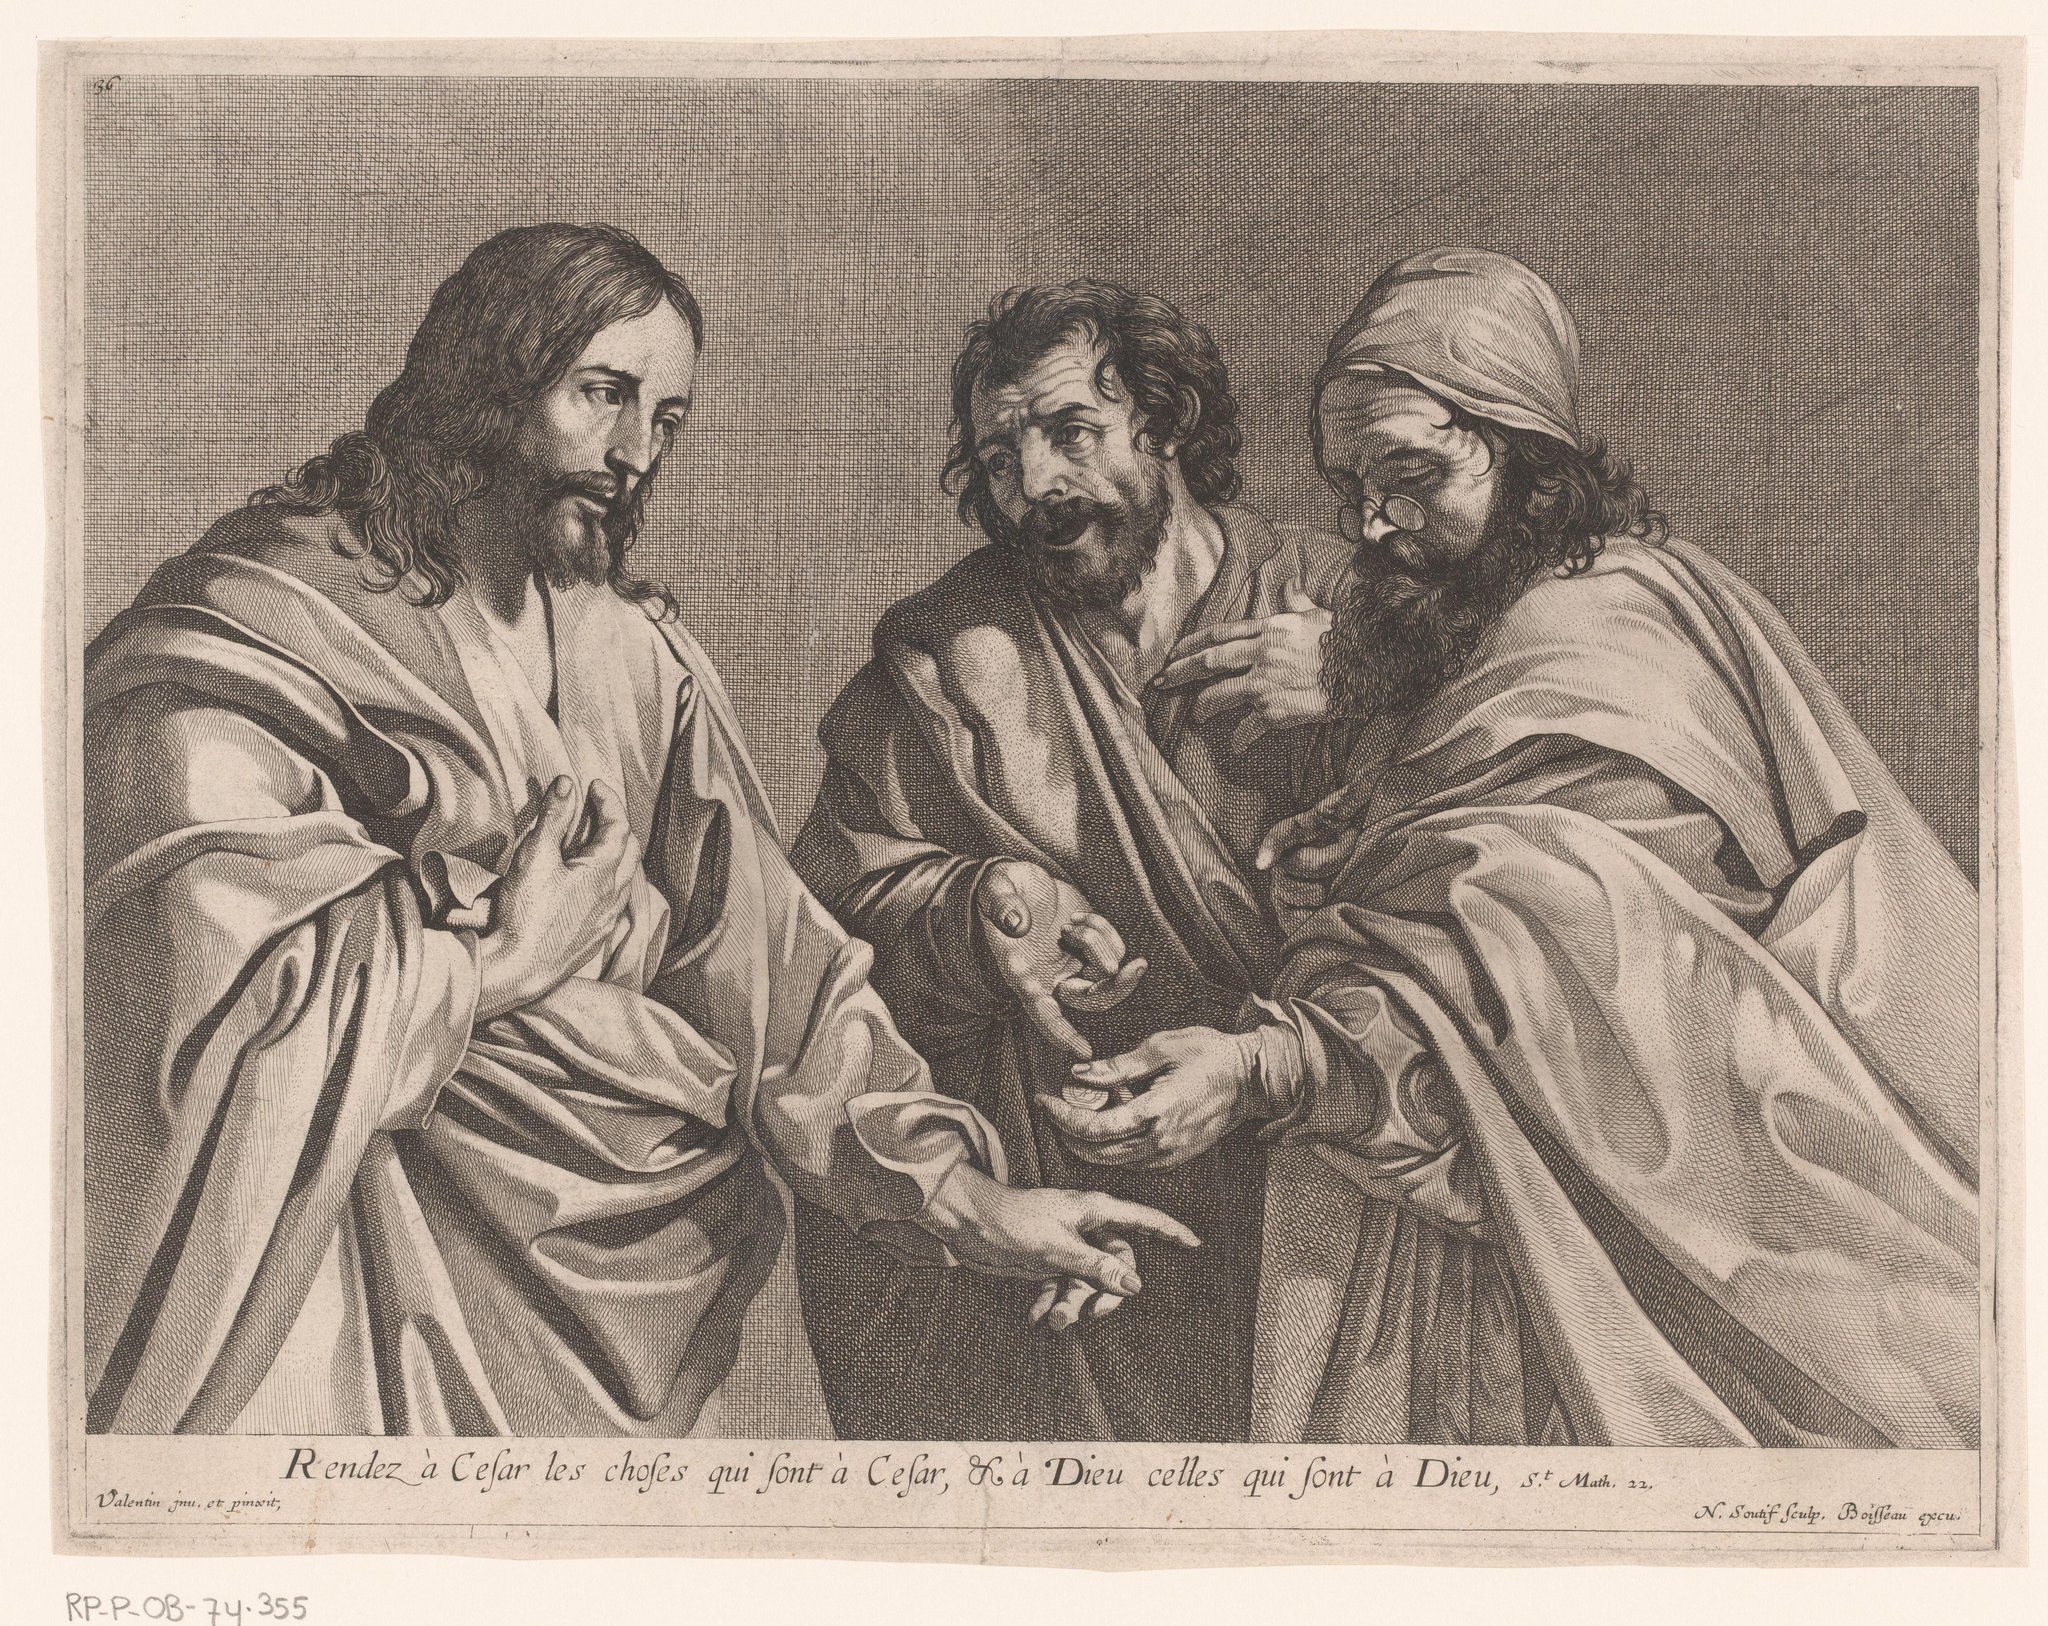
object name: print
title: Christus en de cijnspenning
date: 1620-1720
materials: paper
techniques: engraving, etching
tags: the tribute money (matthew 17:24-27), christ (in the temple) in debate with pharisees about the tribute to caesar (matthew 22:15-22; mark 12:13-17; luke 20:20-26)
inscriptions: collector's mark: Lugt 2228